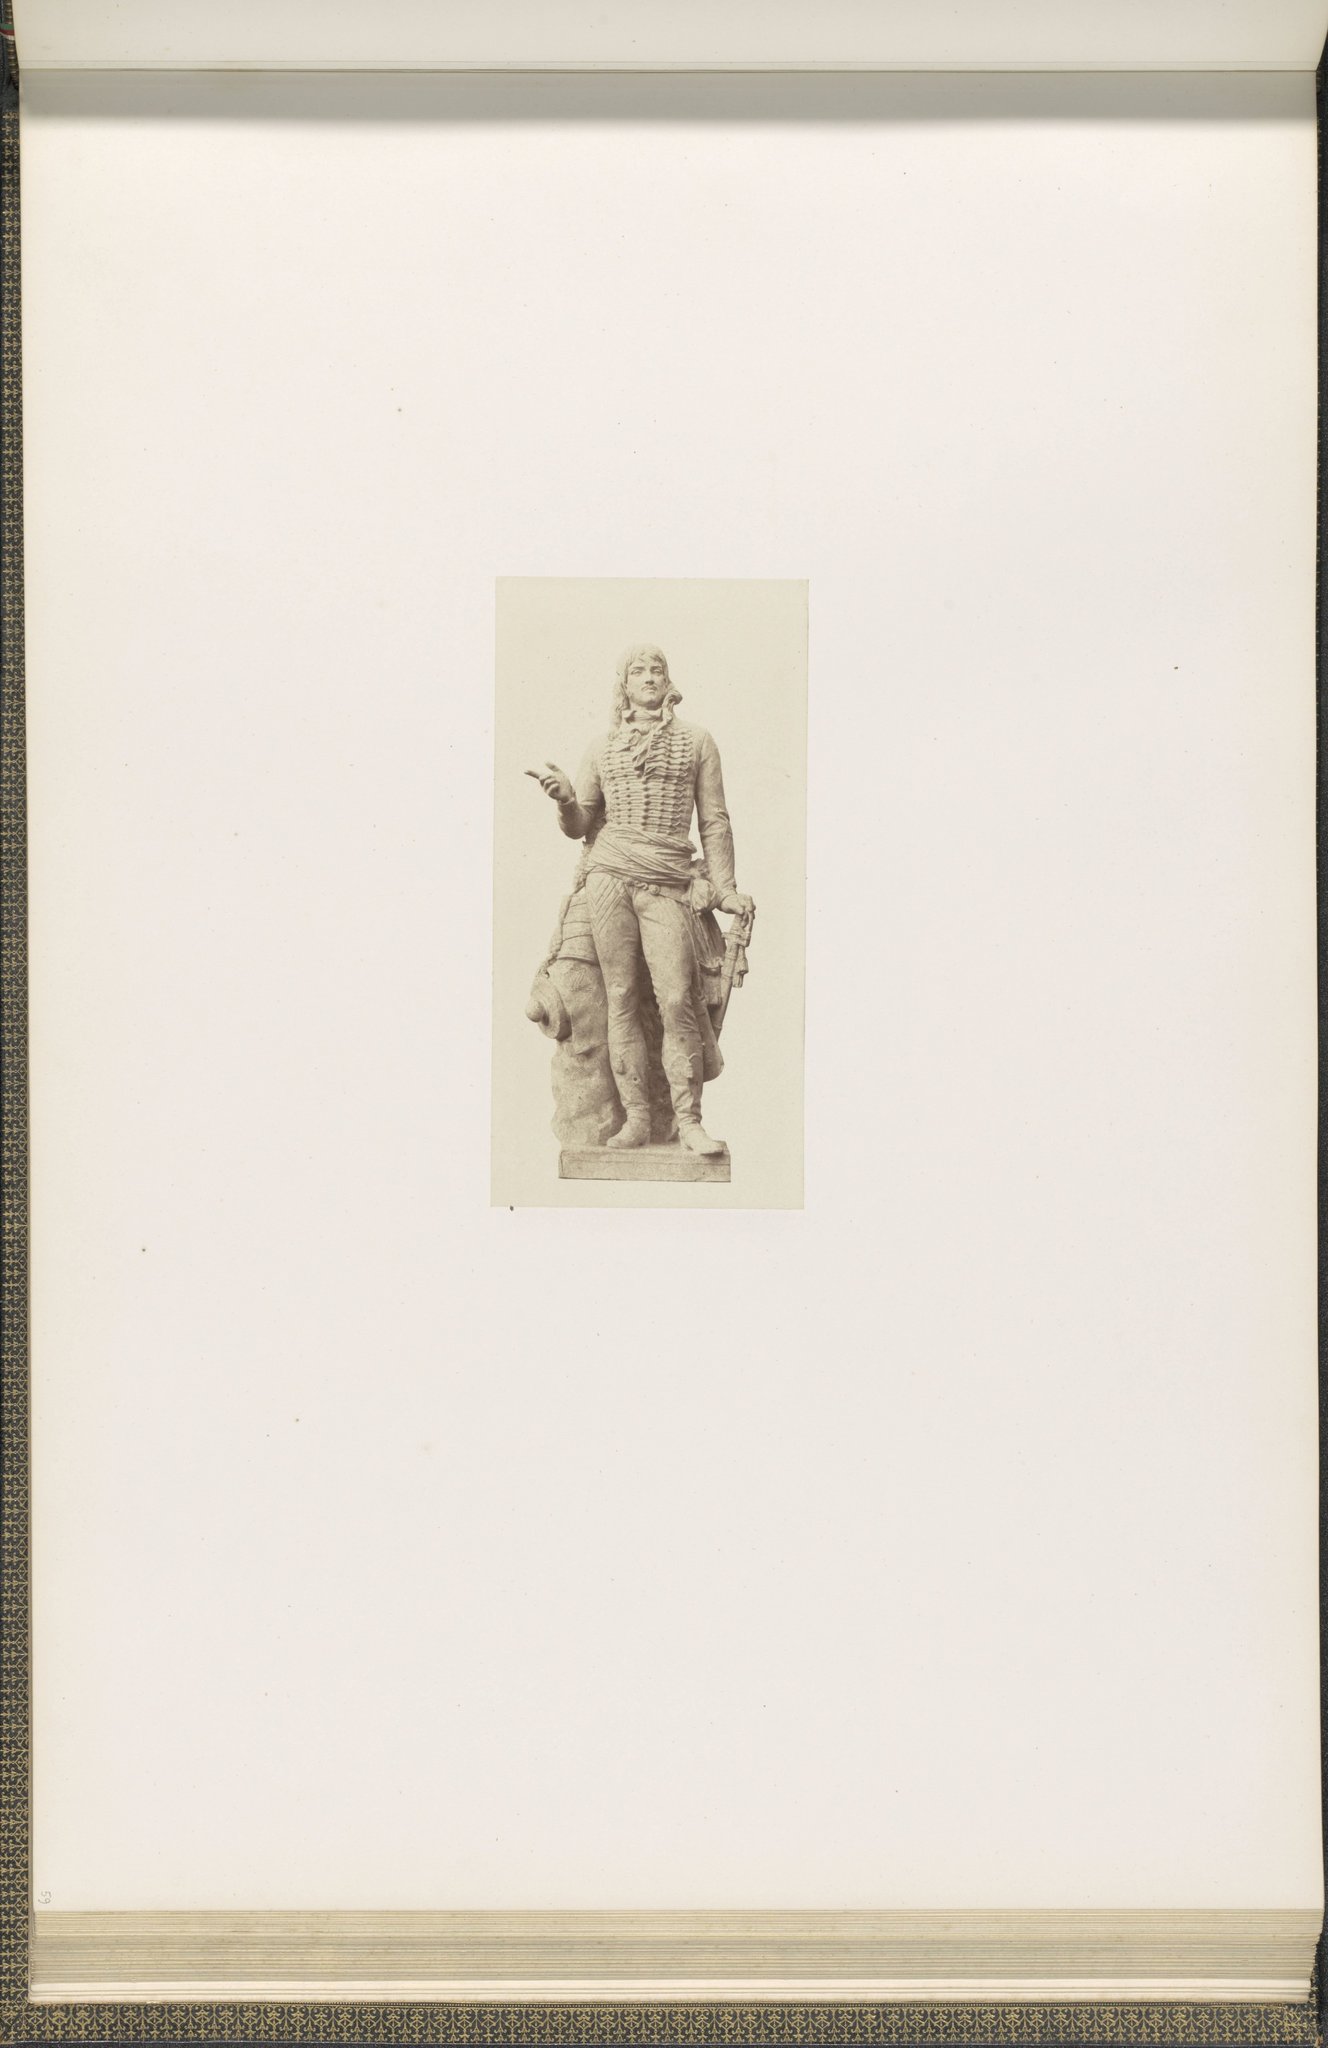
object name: photograph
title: Gipsmodel voor beeldhouwwerk op het Palais du Louvre: "Marceau" door Gabriel Thomas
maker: édouard denis baldus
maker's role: fotograaf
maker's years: 1813-1889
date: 1855-1857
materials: paper, photographic support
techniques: salted paper print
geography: paris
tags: piece of sculpture, reproduction of a piece of sculpture, permanent exhibition, museum, paris, tuileries palace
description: Onderdeel van Réunion des Tuileries au Louvre 1852-1857, album 4.